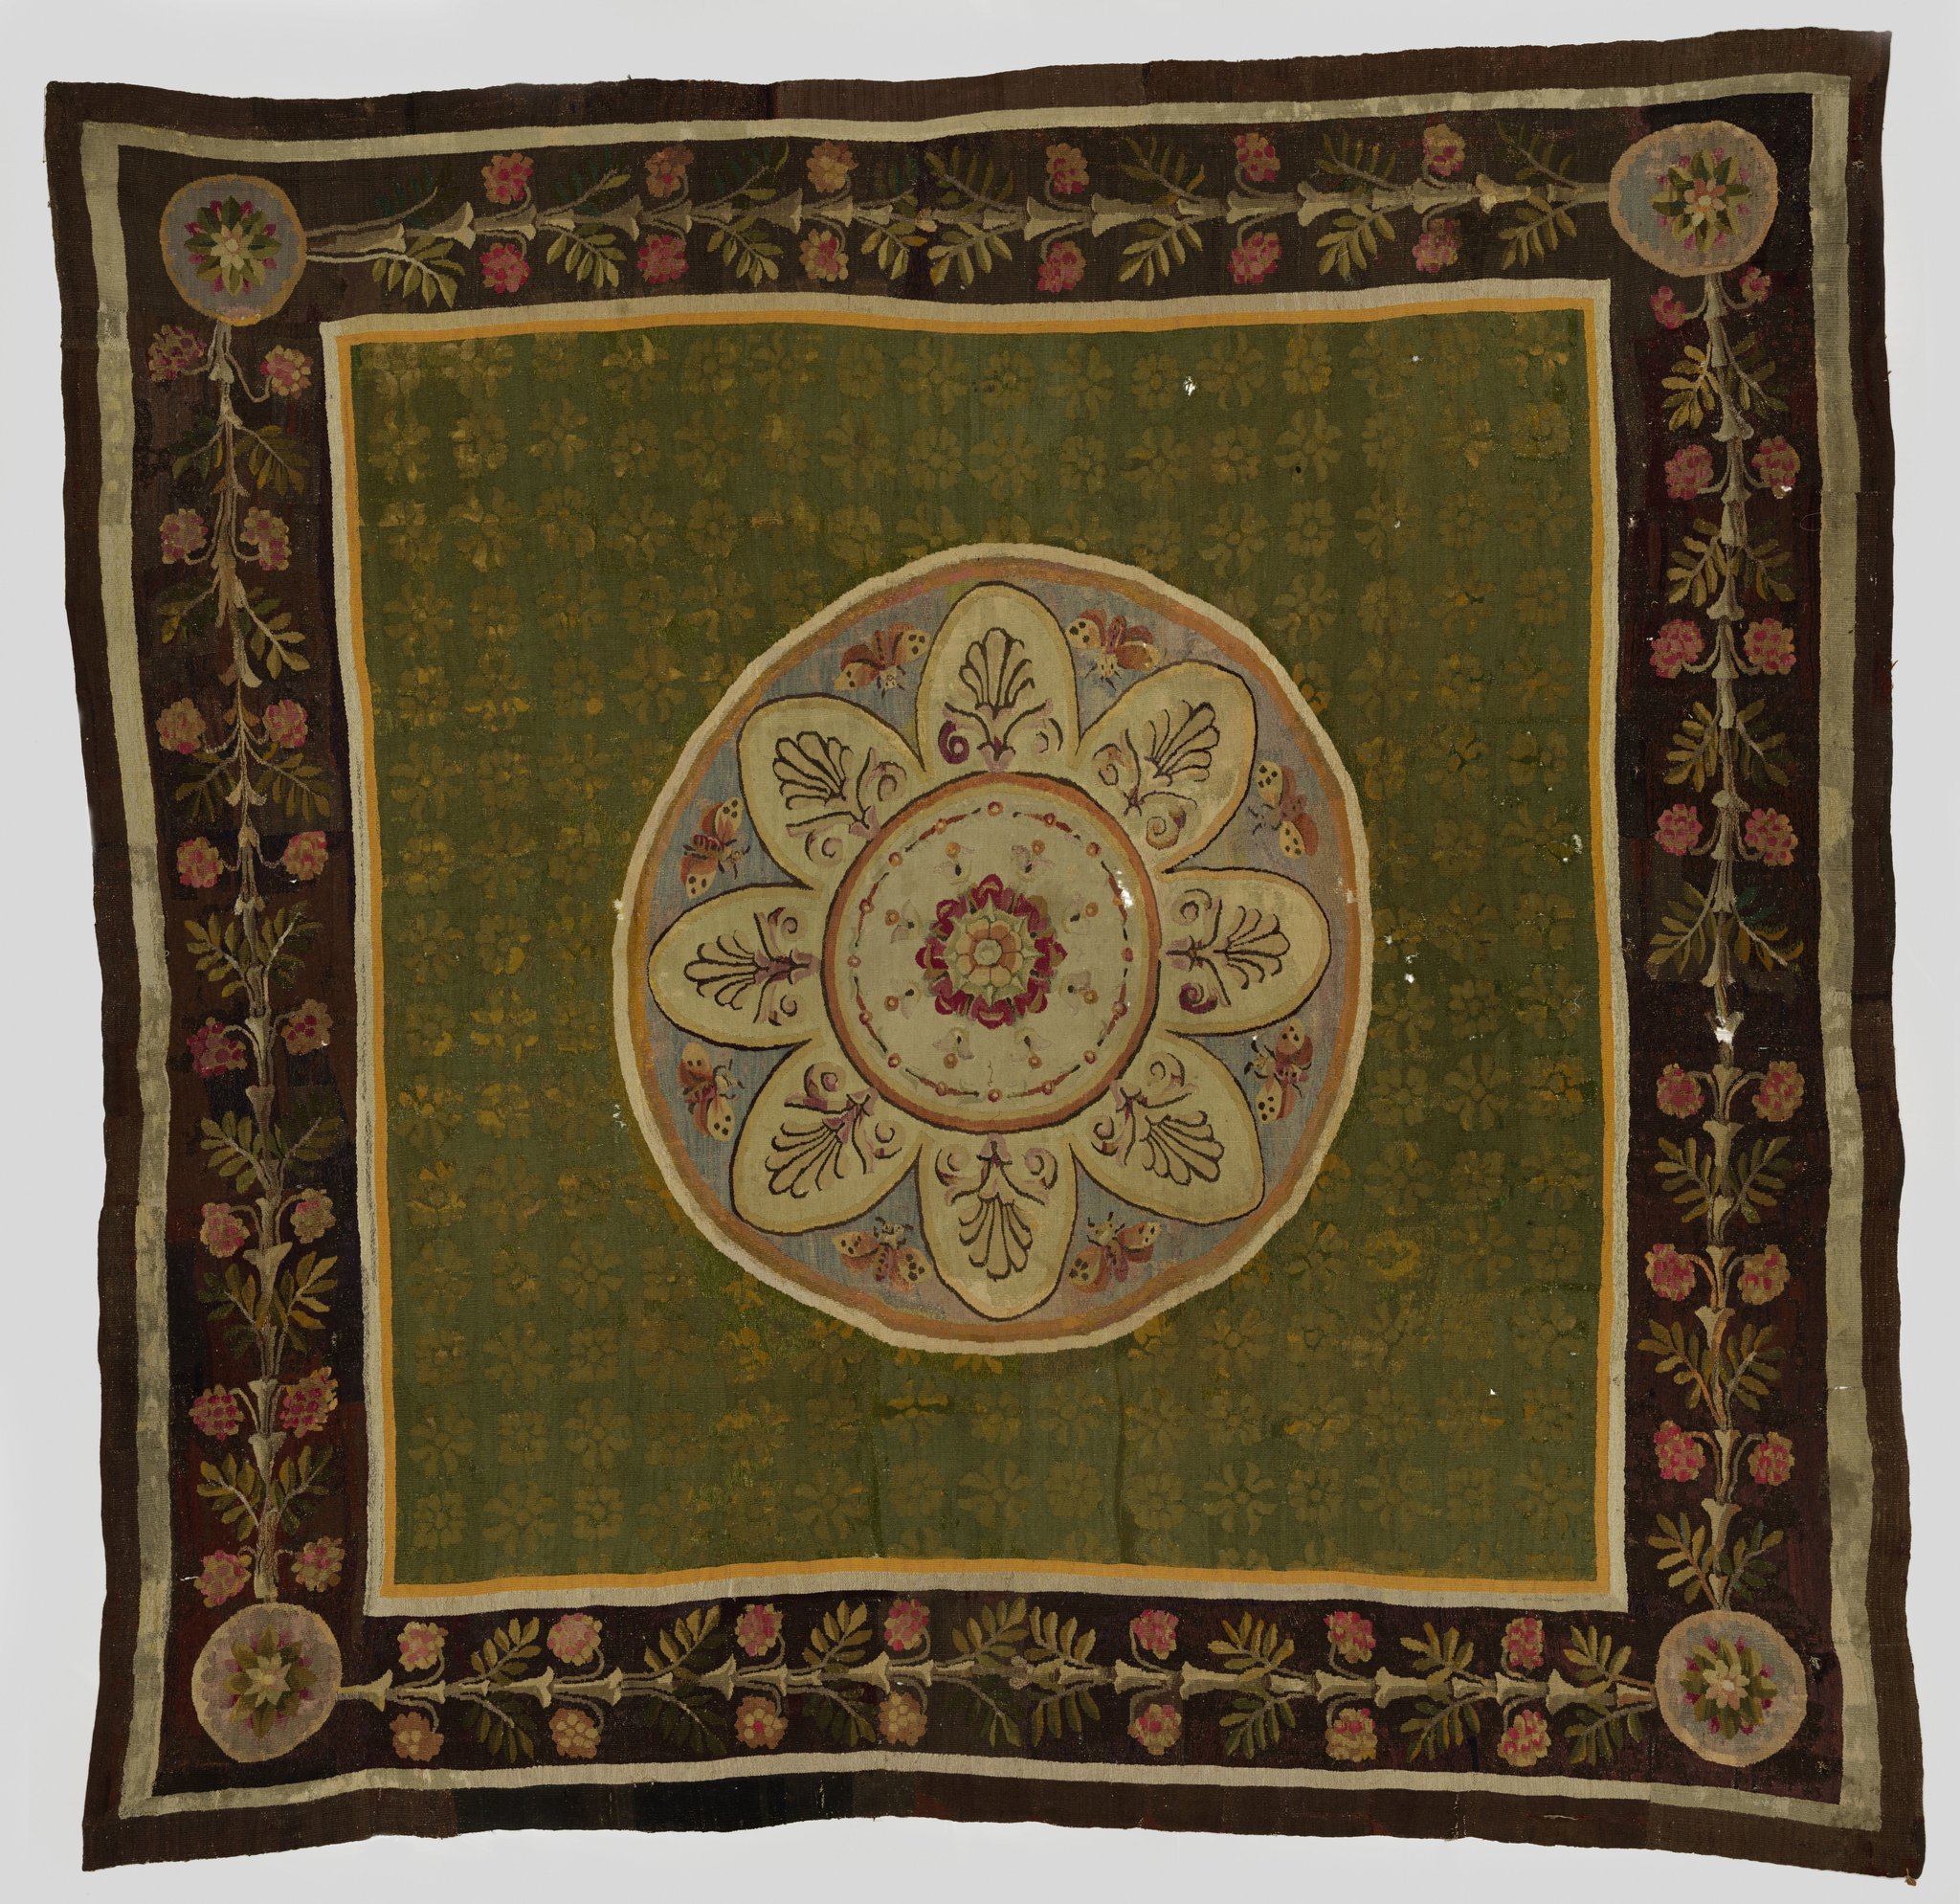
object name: carpet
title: Vloertapijt van tapisserie versierd met bloemen en bladeren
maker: Anonymous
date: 1800-1825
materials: wool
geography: aubusson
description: Vloertapijt van grof geweven tapisserie. Middenveld: op een groene fond met rijen twee soortige rozetten van lichter groen, staat een rond midden medaillon met lichtblauwe fond, waarop vliegende bijen en een rozet met palmetvulling in beige-bruine-rose. Rand: op een donkerbruin fond ontspringen aan ronde hoekmedaillons takken met telkens twee rode trosbloemen en twee bladeren. Effen tussenlijsten van grijswit en geel. Buitenzomen van donkerbruin en fragmentarisch oranje. Het tapijt is voor het grootste deel gerestaureerd.